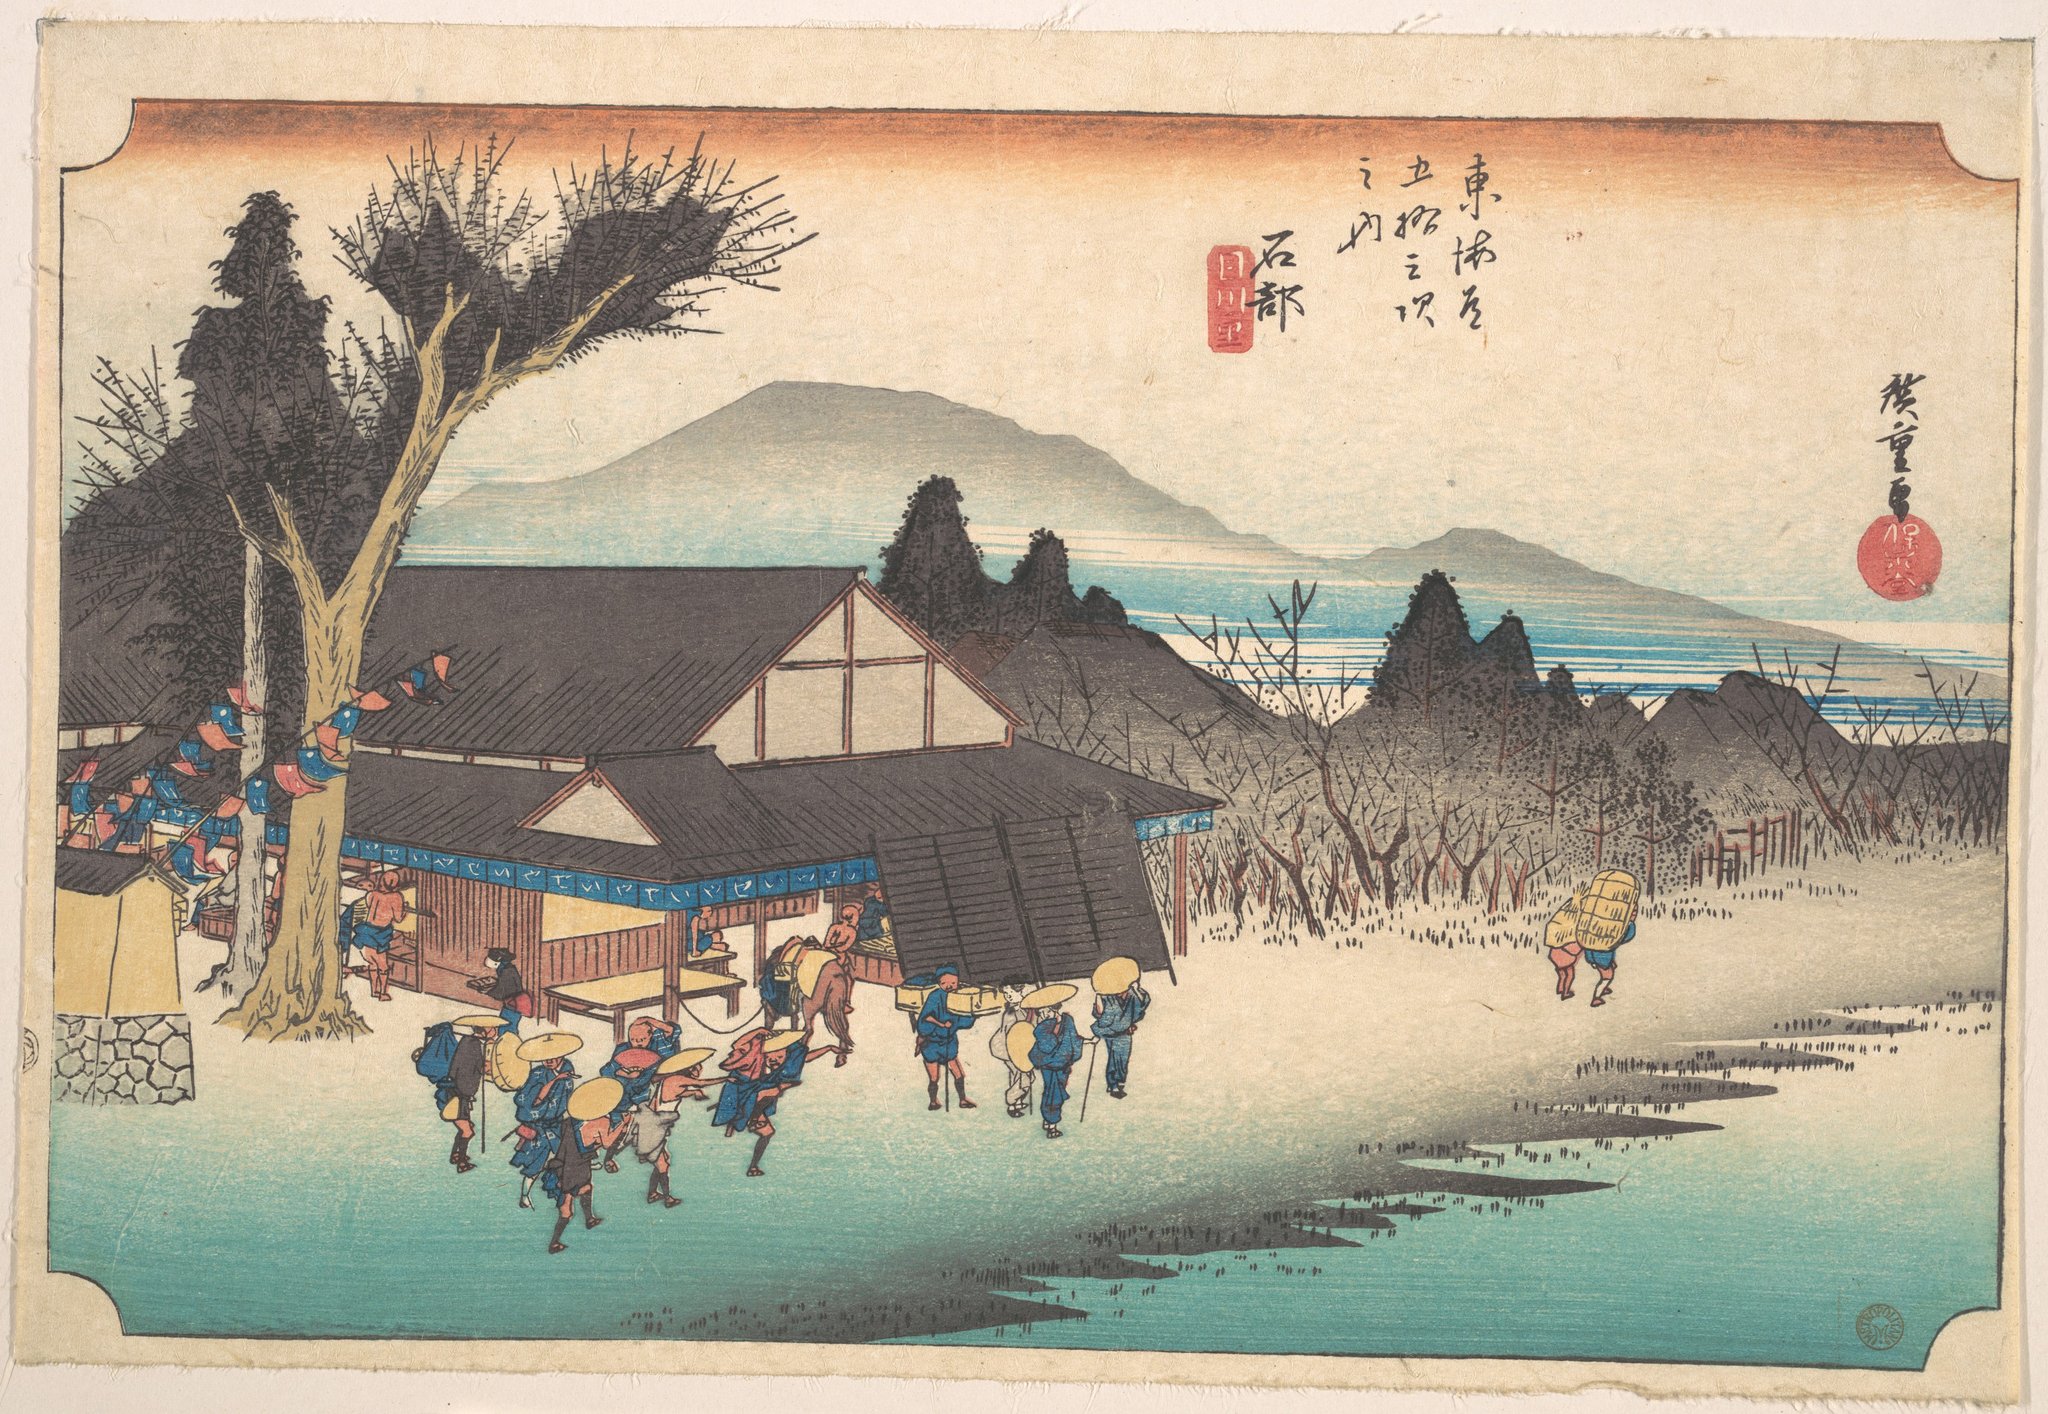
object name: print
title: Ishibe, Megawa Sato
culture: japanese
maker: utagawa hiroshige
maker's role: artist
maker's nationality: japanese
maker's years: 1797-1858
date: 1834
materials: ink, paper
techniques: woodblock print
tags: human figures,houses,hills,trees